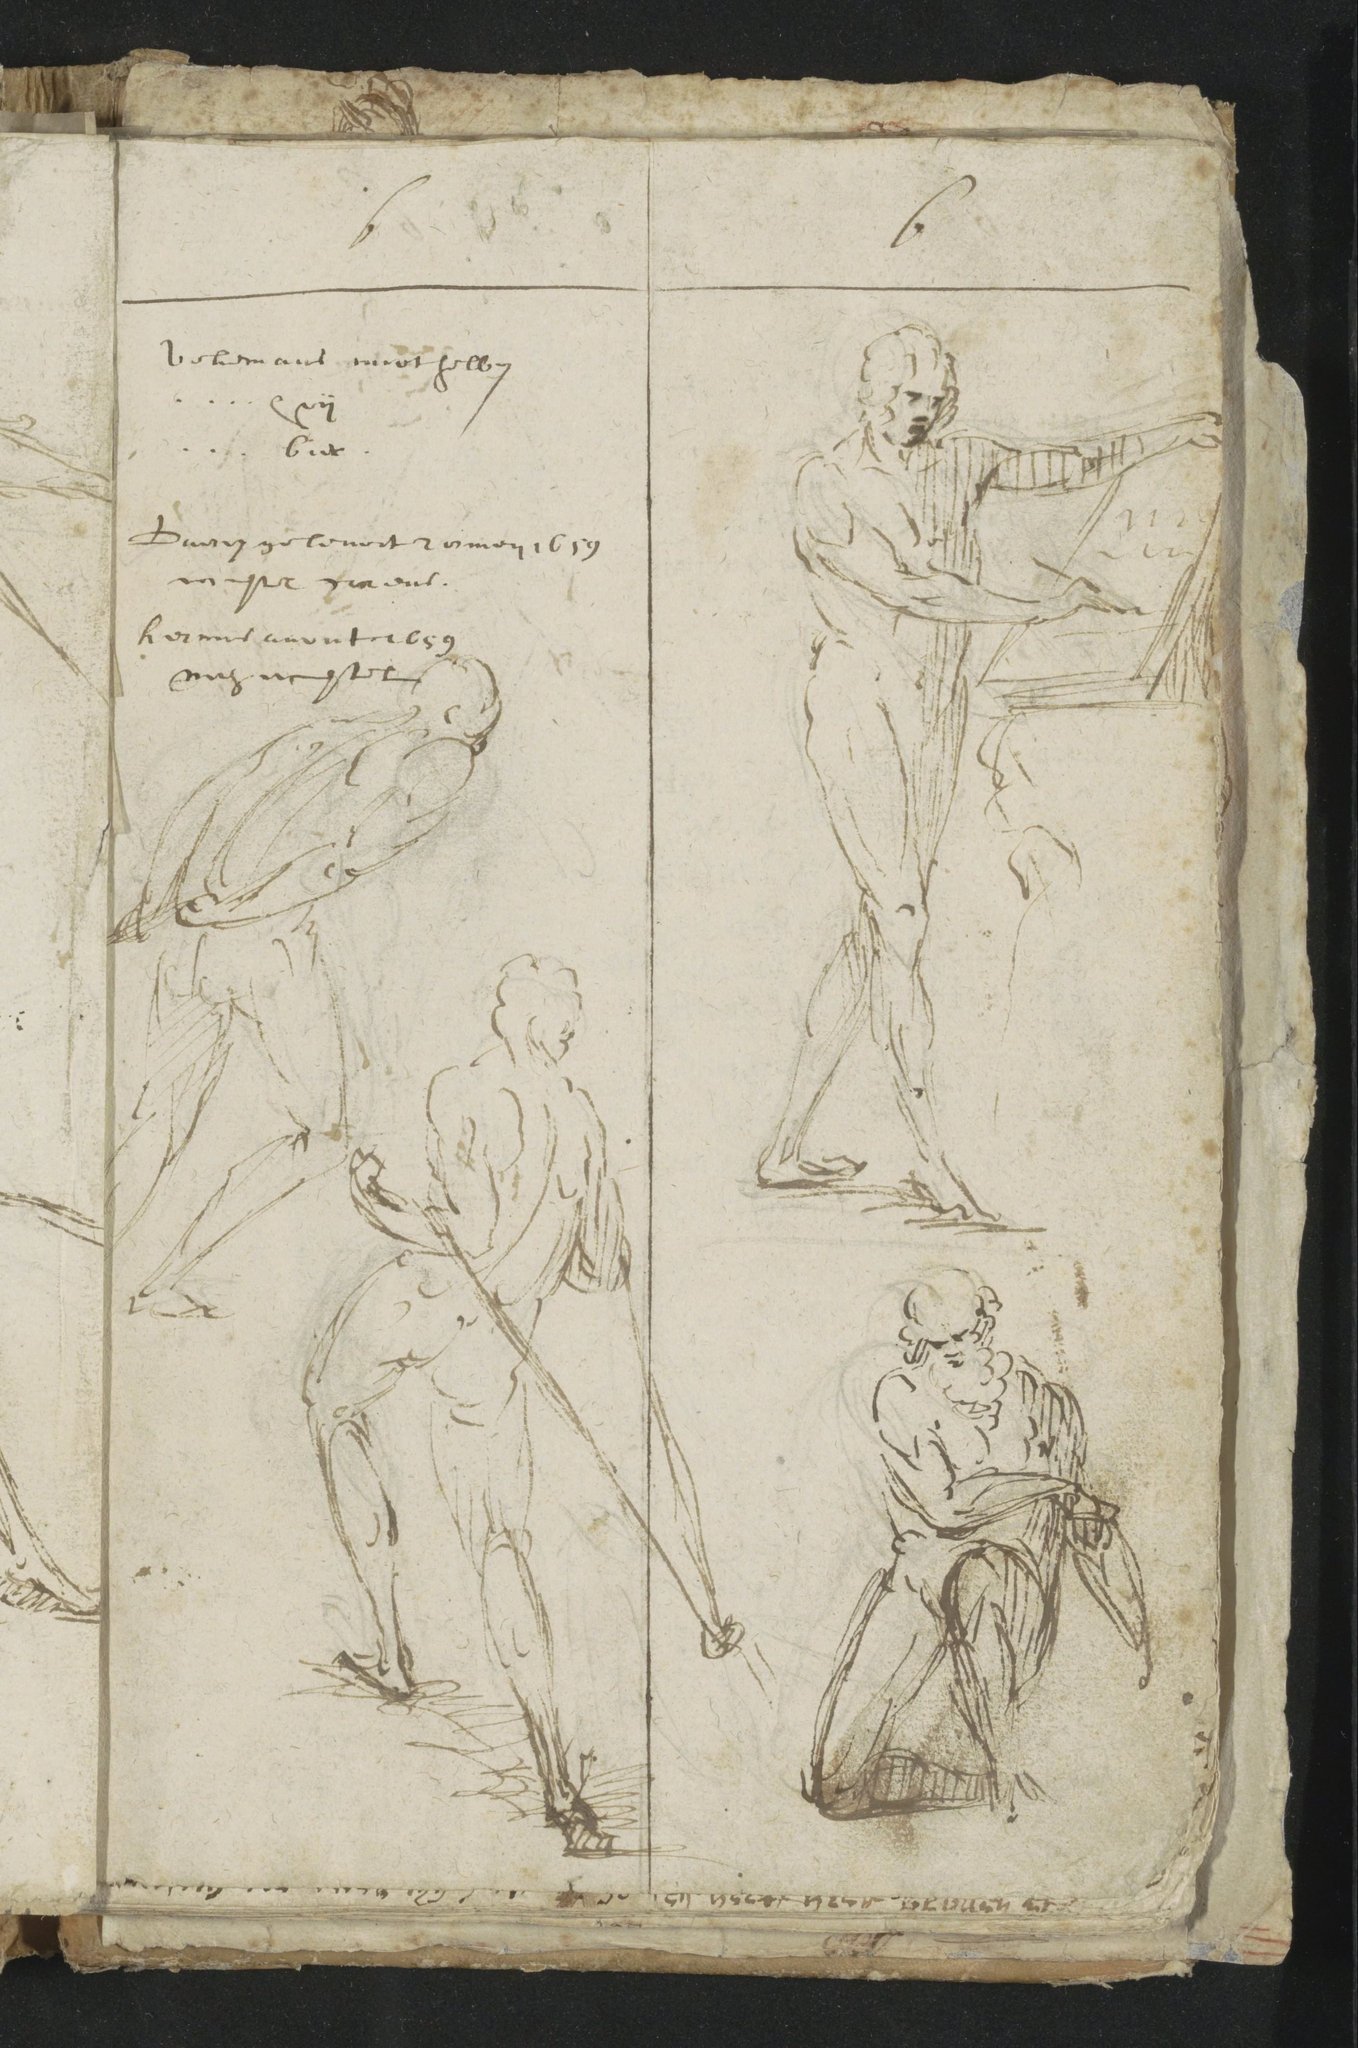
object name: sketchbook leaf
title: Mannen die lasten trekken en een man schrijvend op een tablet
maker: Anonymous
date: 1659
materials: ink, paper, pencil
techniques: pen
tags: writing tablets, drawing, pulling something, movements of the human body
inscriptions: date and inscription: ‘b b/ [...] / [...] 28 may 1659/ [...]’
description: Tevens een studie van een knielende man met een voorwerp in de hand of aan de arm. Blad 2 recto uit een schetsboek met 33 bladen.